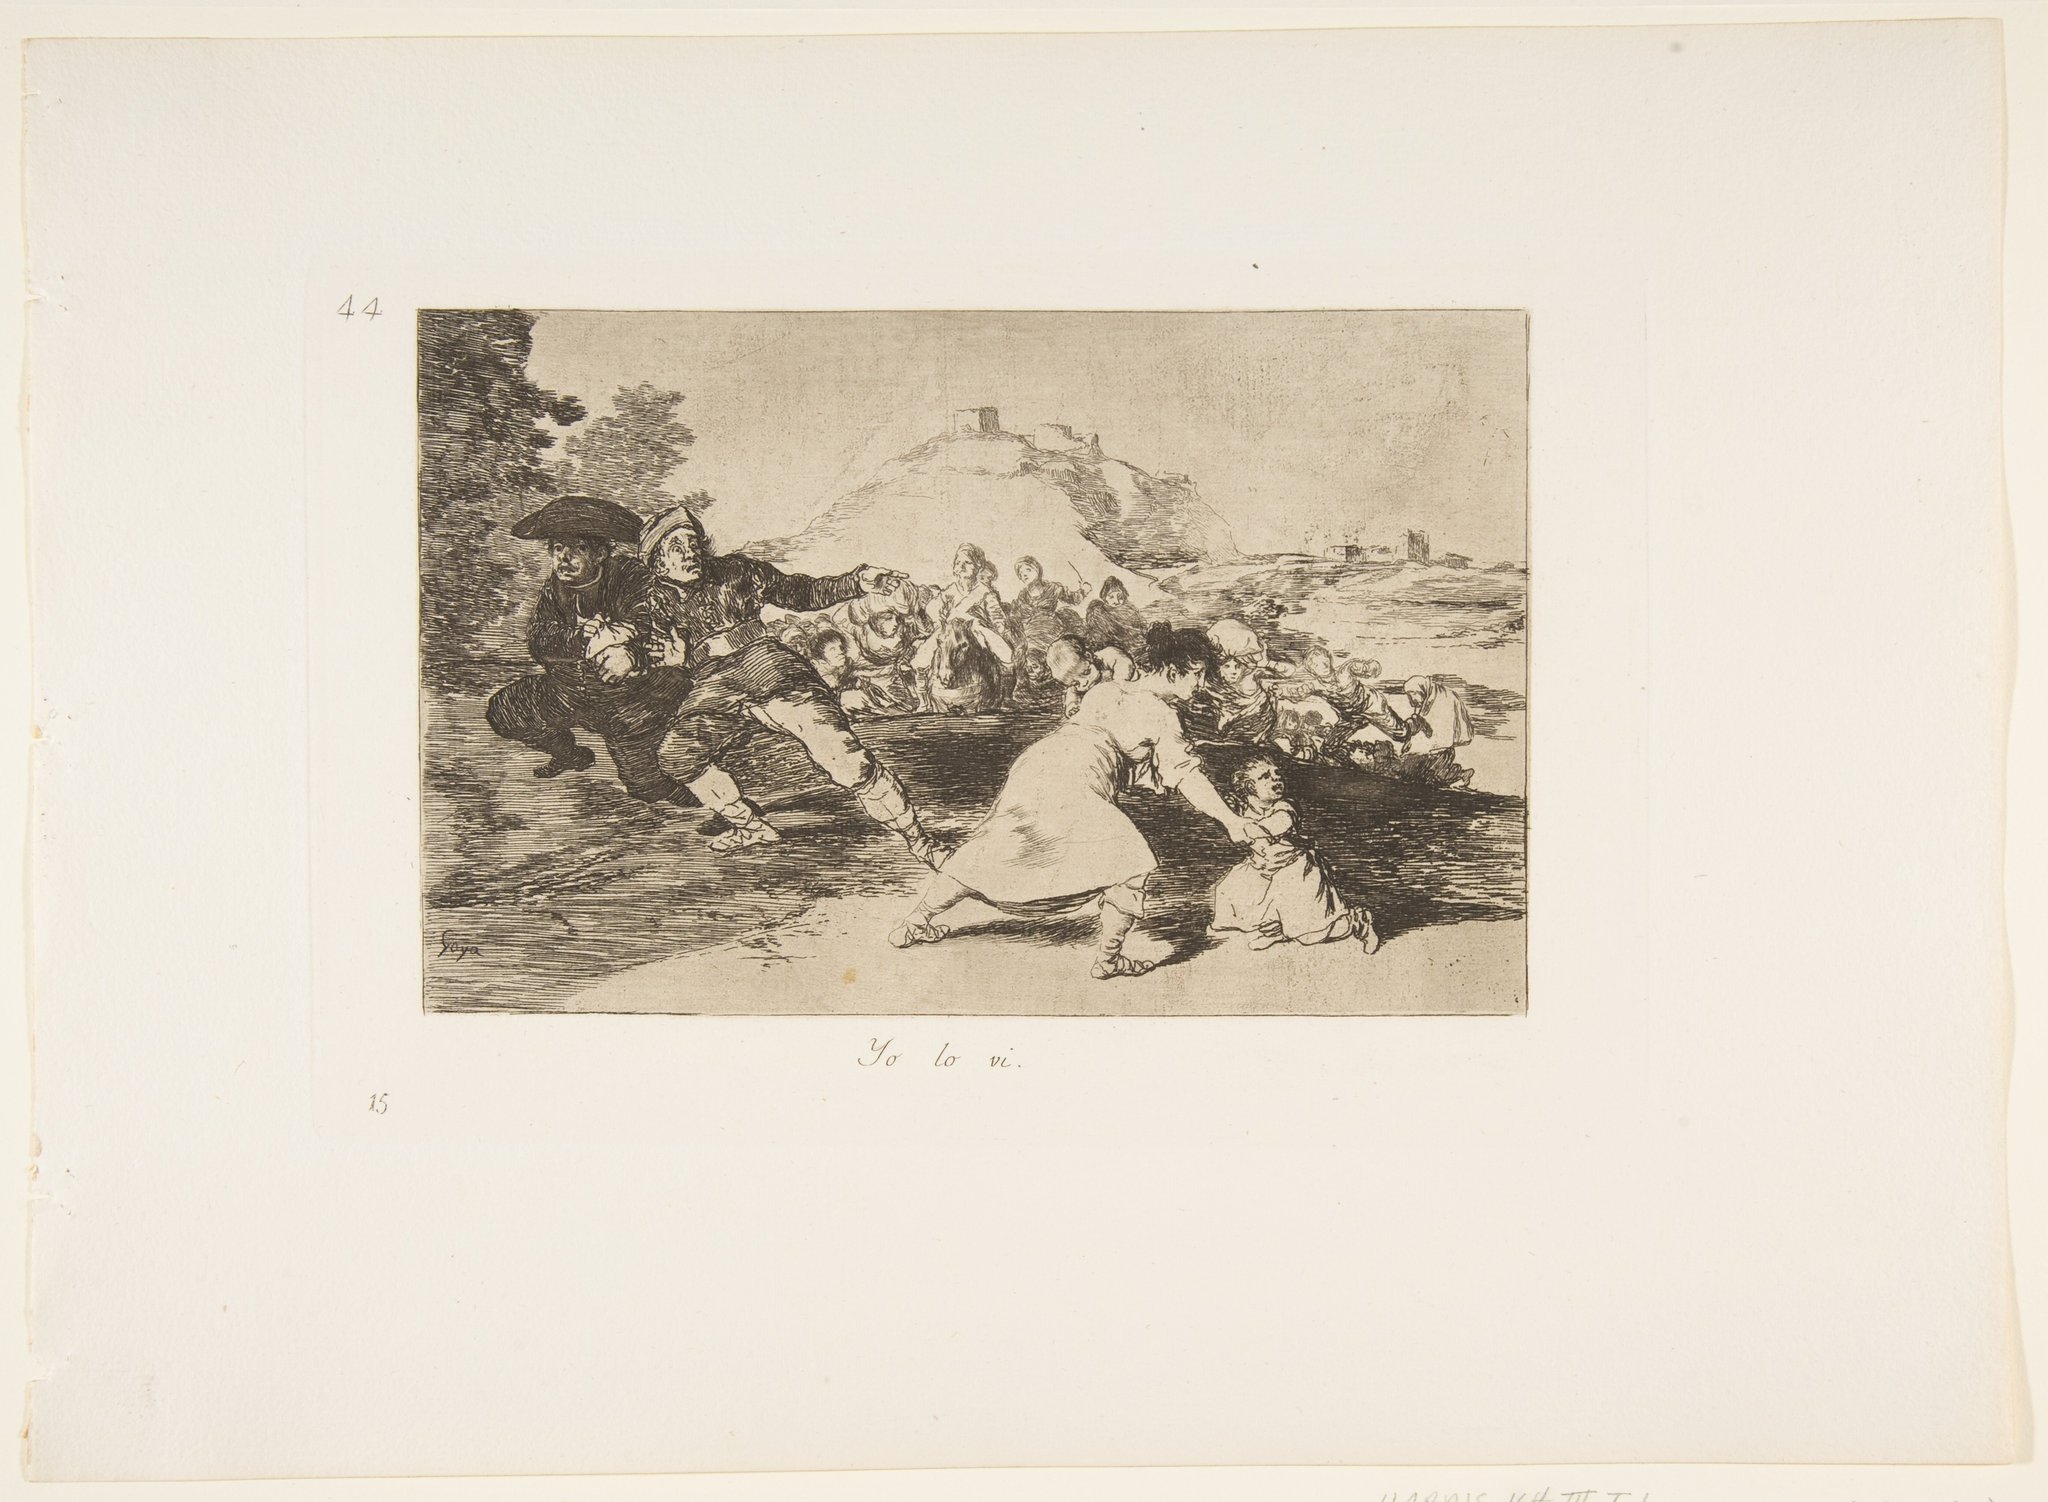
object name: print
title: Plate 44 from "The Disasters of War" (Los Desastres de la Guerra): I saw it (Yo lo vi)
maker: goya (francisco de goya y lucientes)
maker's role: artist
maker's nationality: spanish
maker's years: 1746-1828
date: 1810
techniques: engraving, drypoint, etching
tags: children,men,women